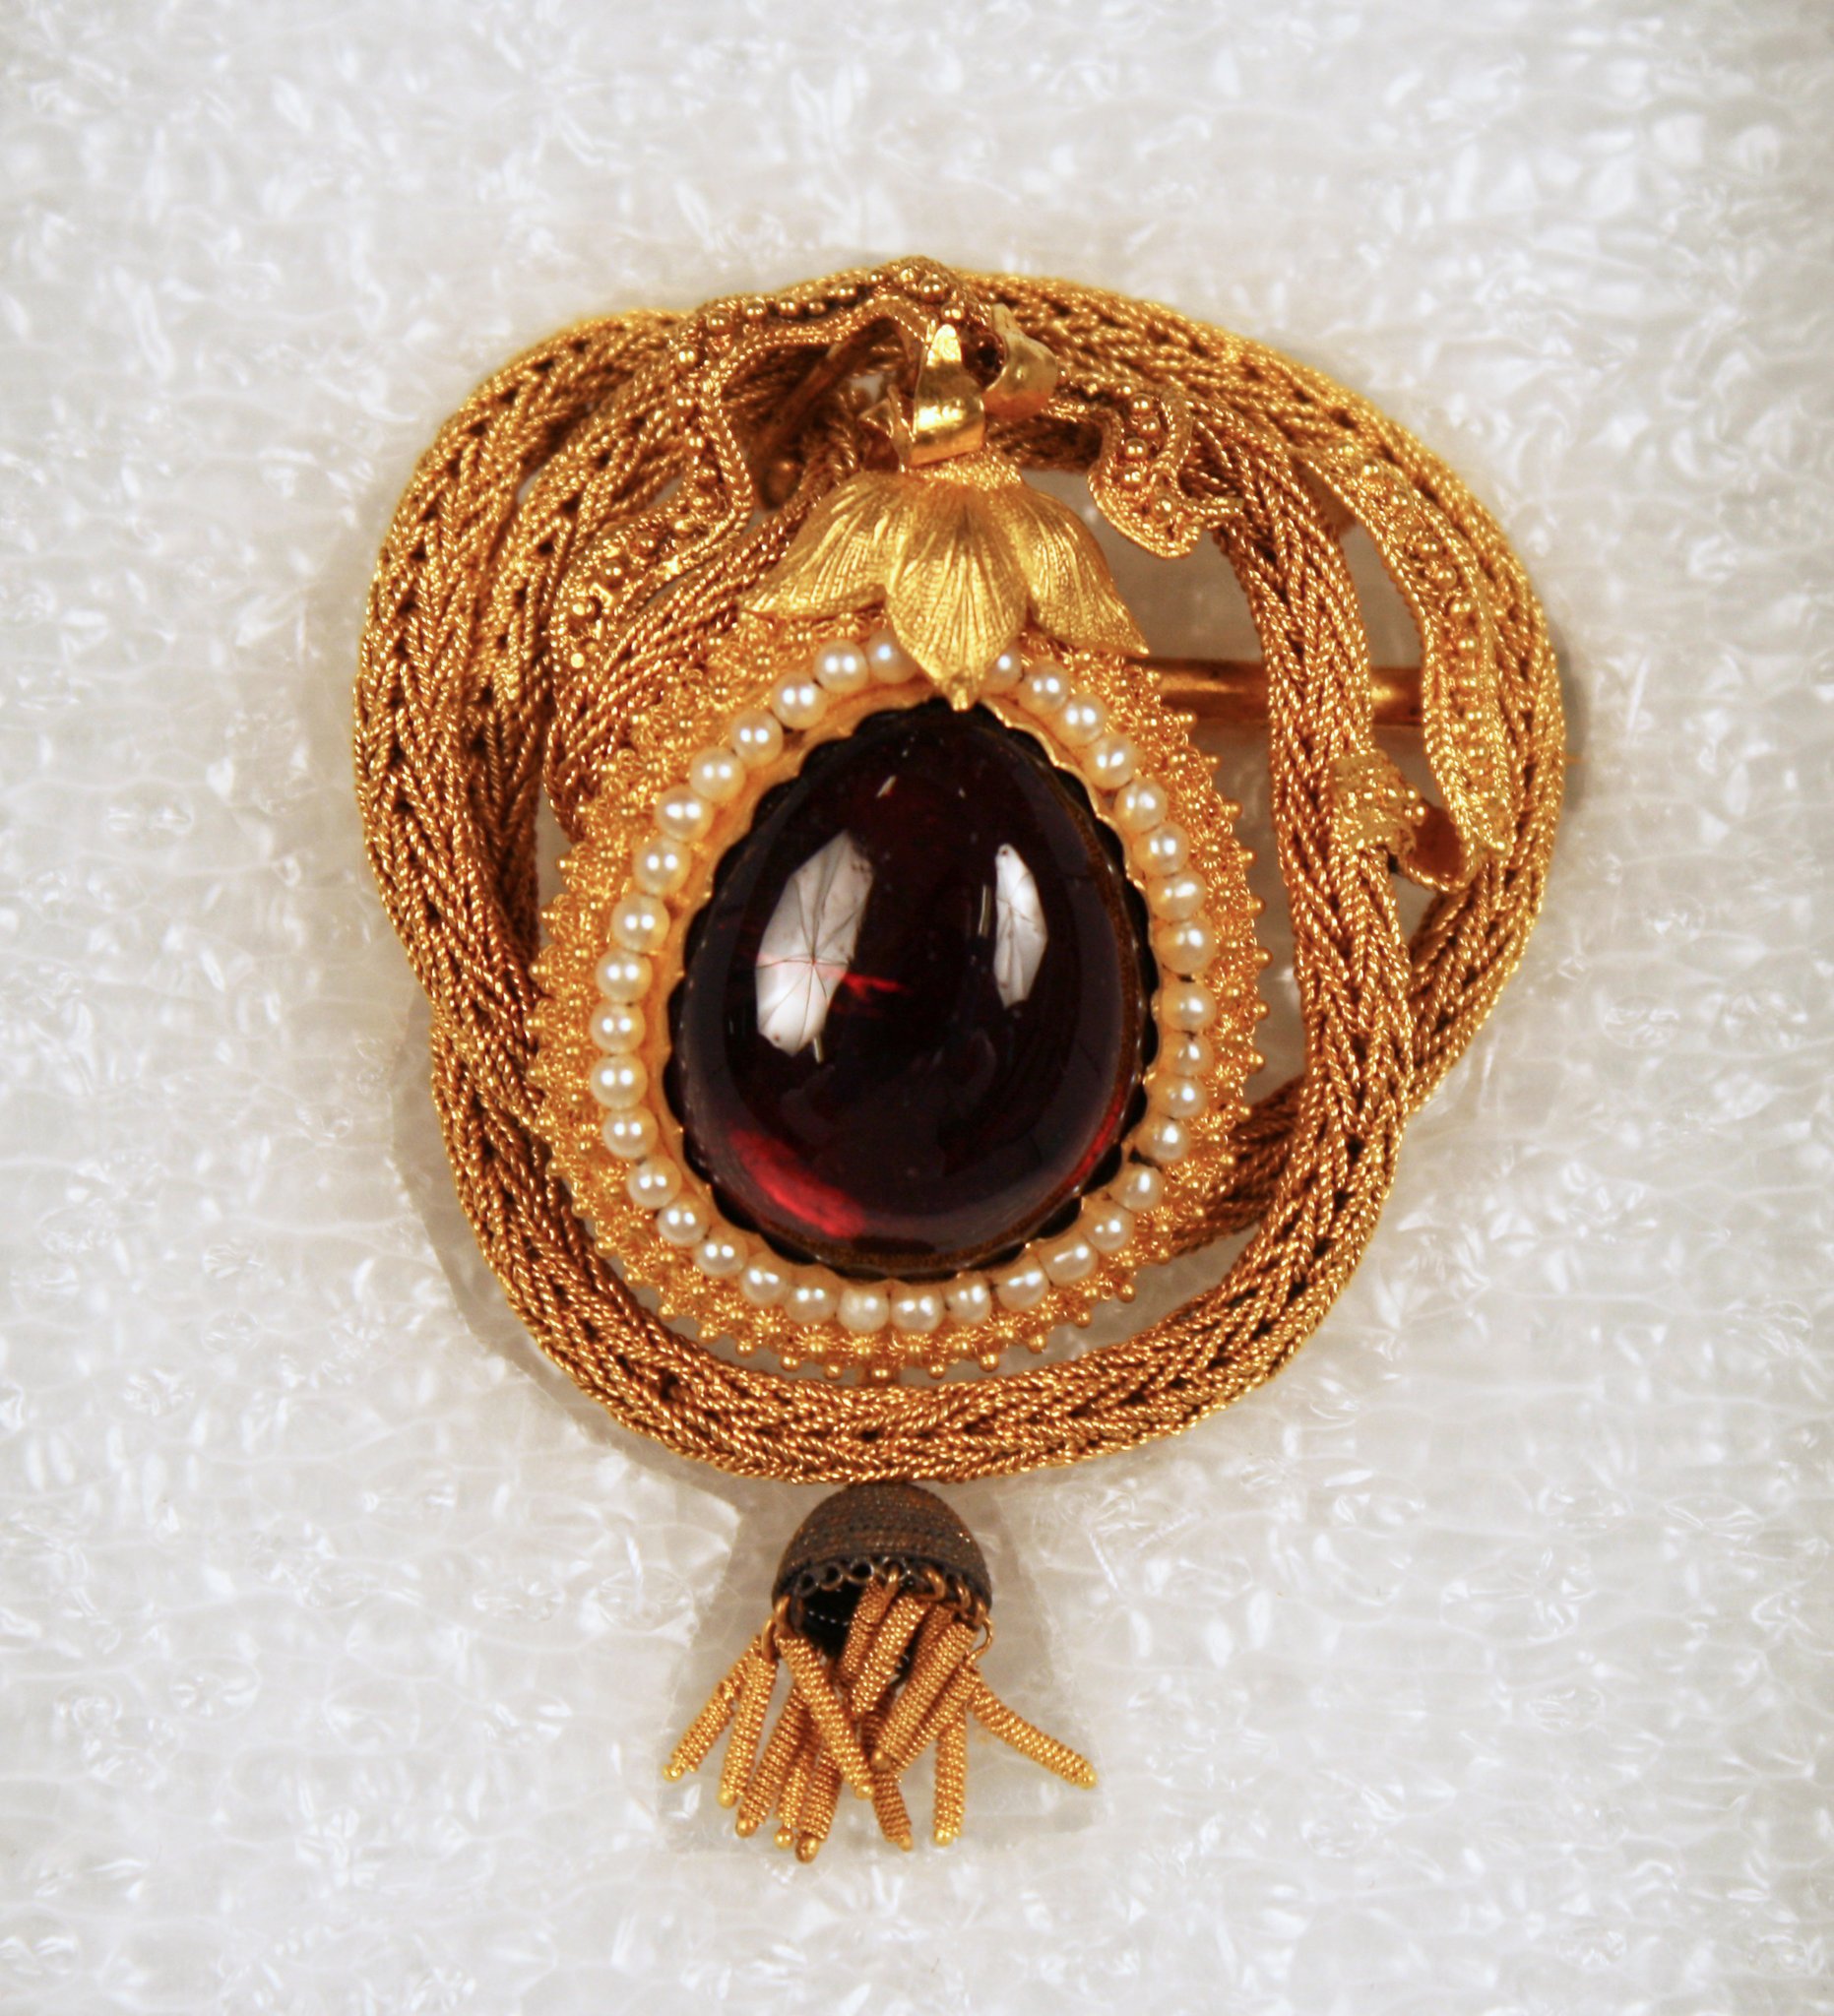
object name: brooch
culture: american or european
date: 1850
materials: gemstone, gold, pearl